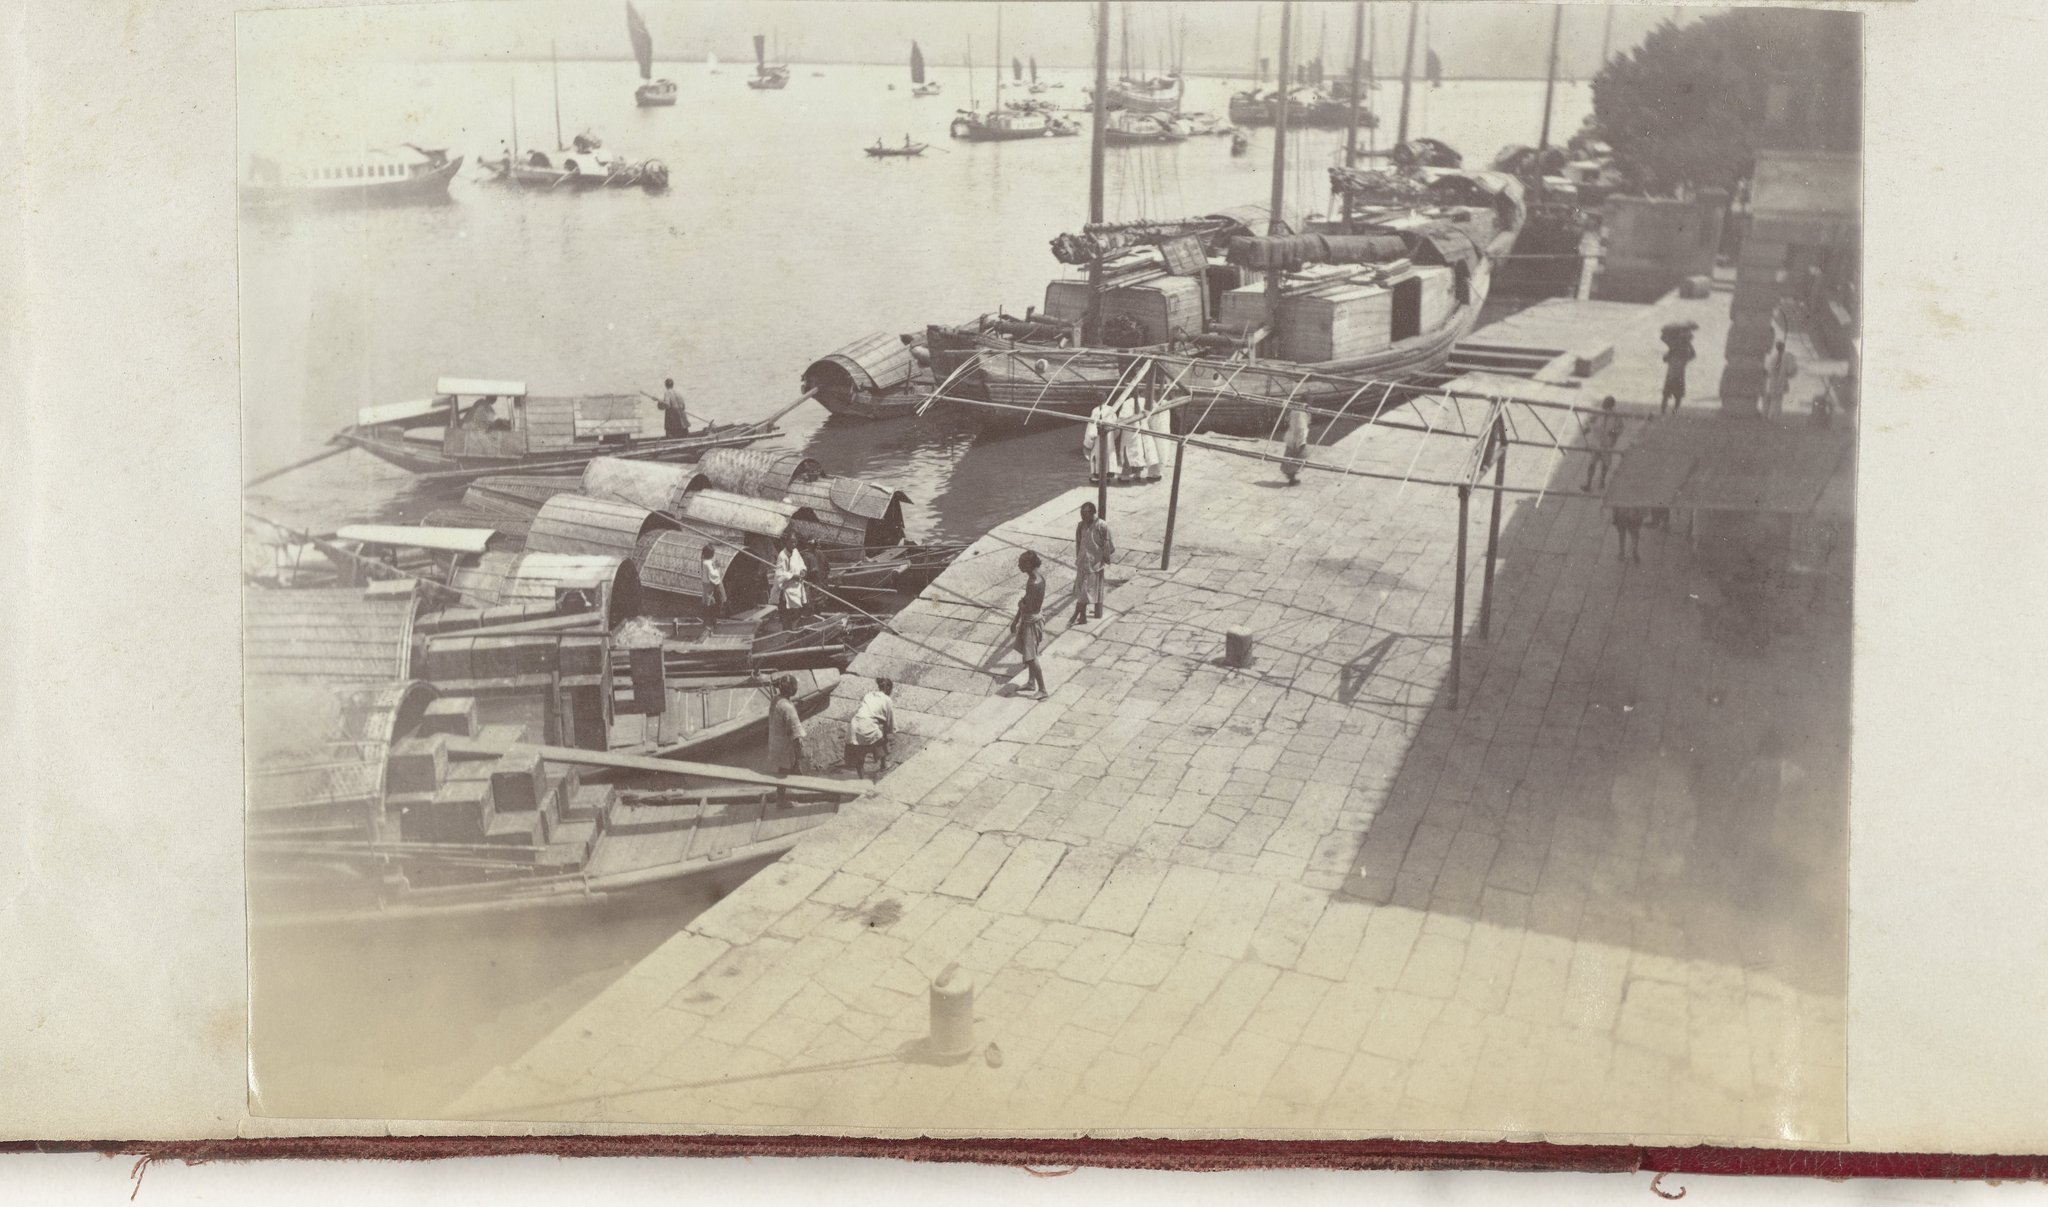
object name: photograph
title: Gezicht op een kade en aangemeerde schepen, China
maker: Anonymous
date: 1879-1890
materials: paper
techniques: albumen print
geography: china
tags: ship bound for the harbour, pier, quay, wharf, china